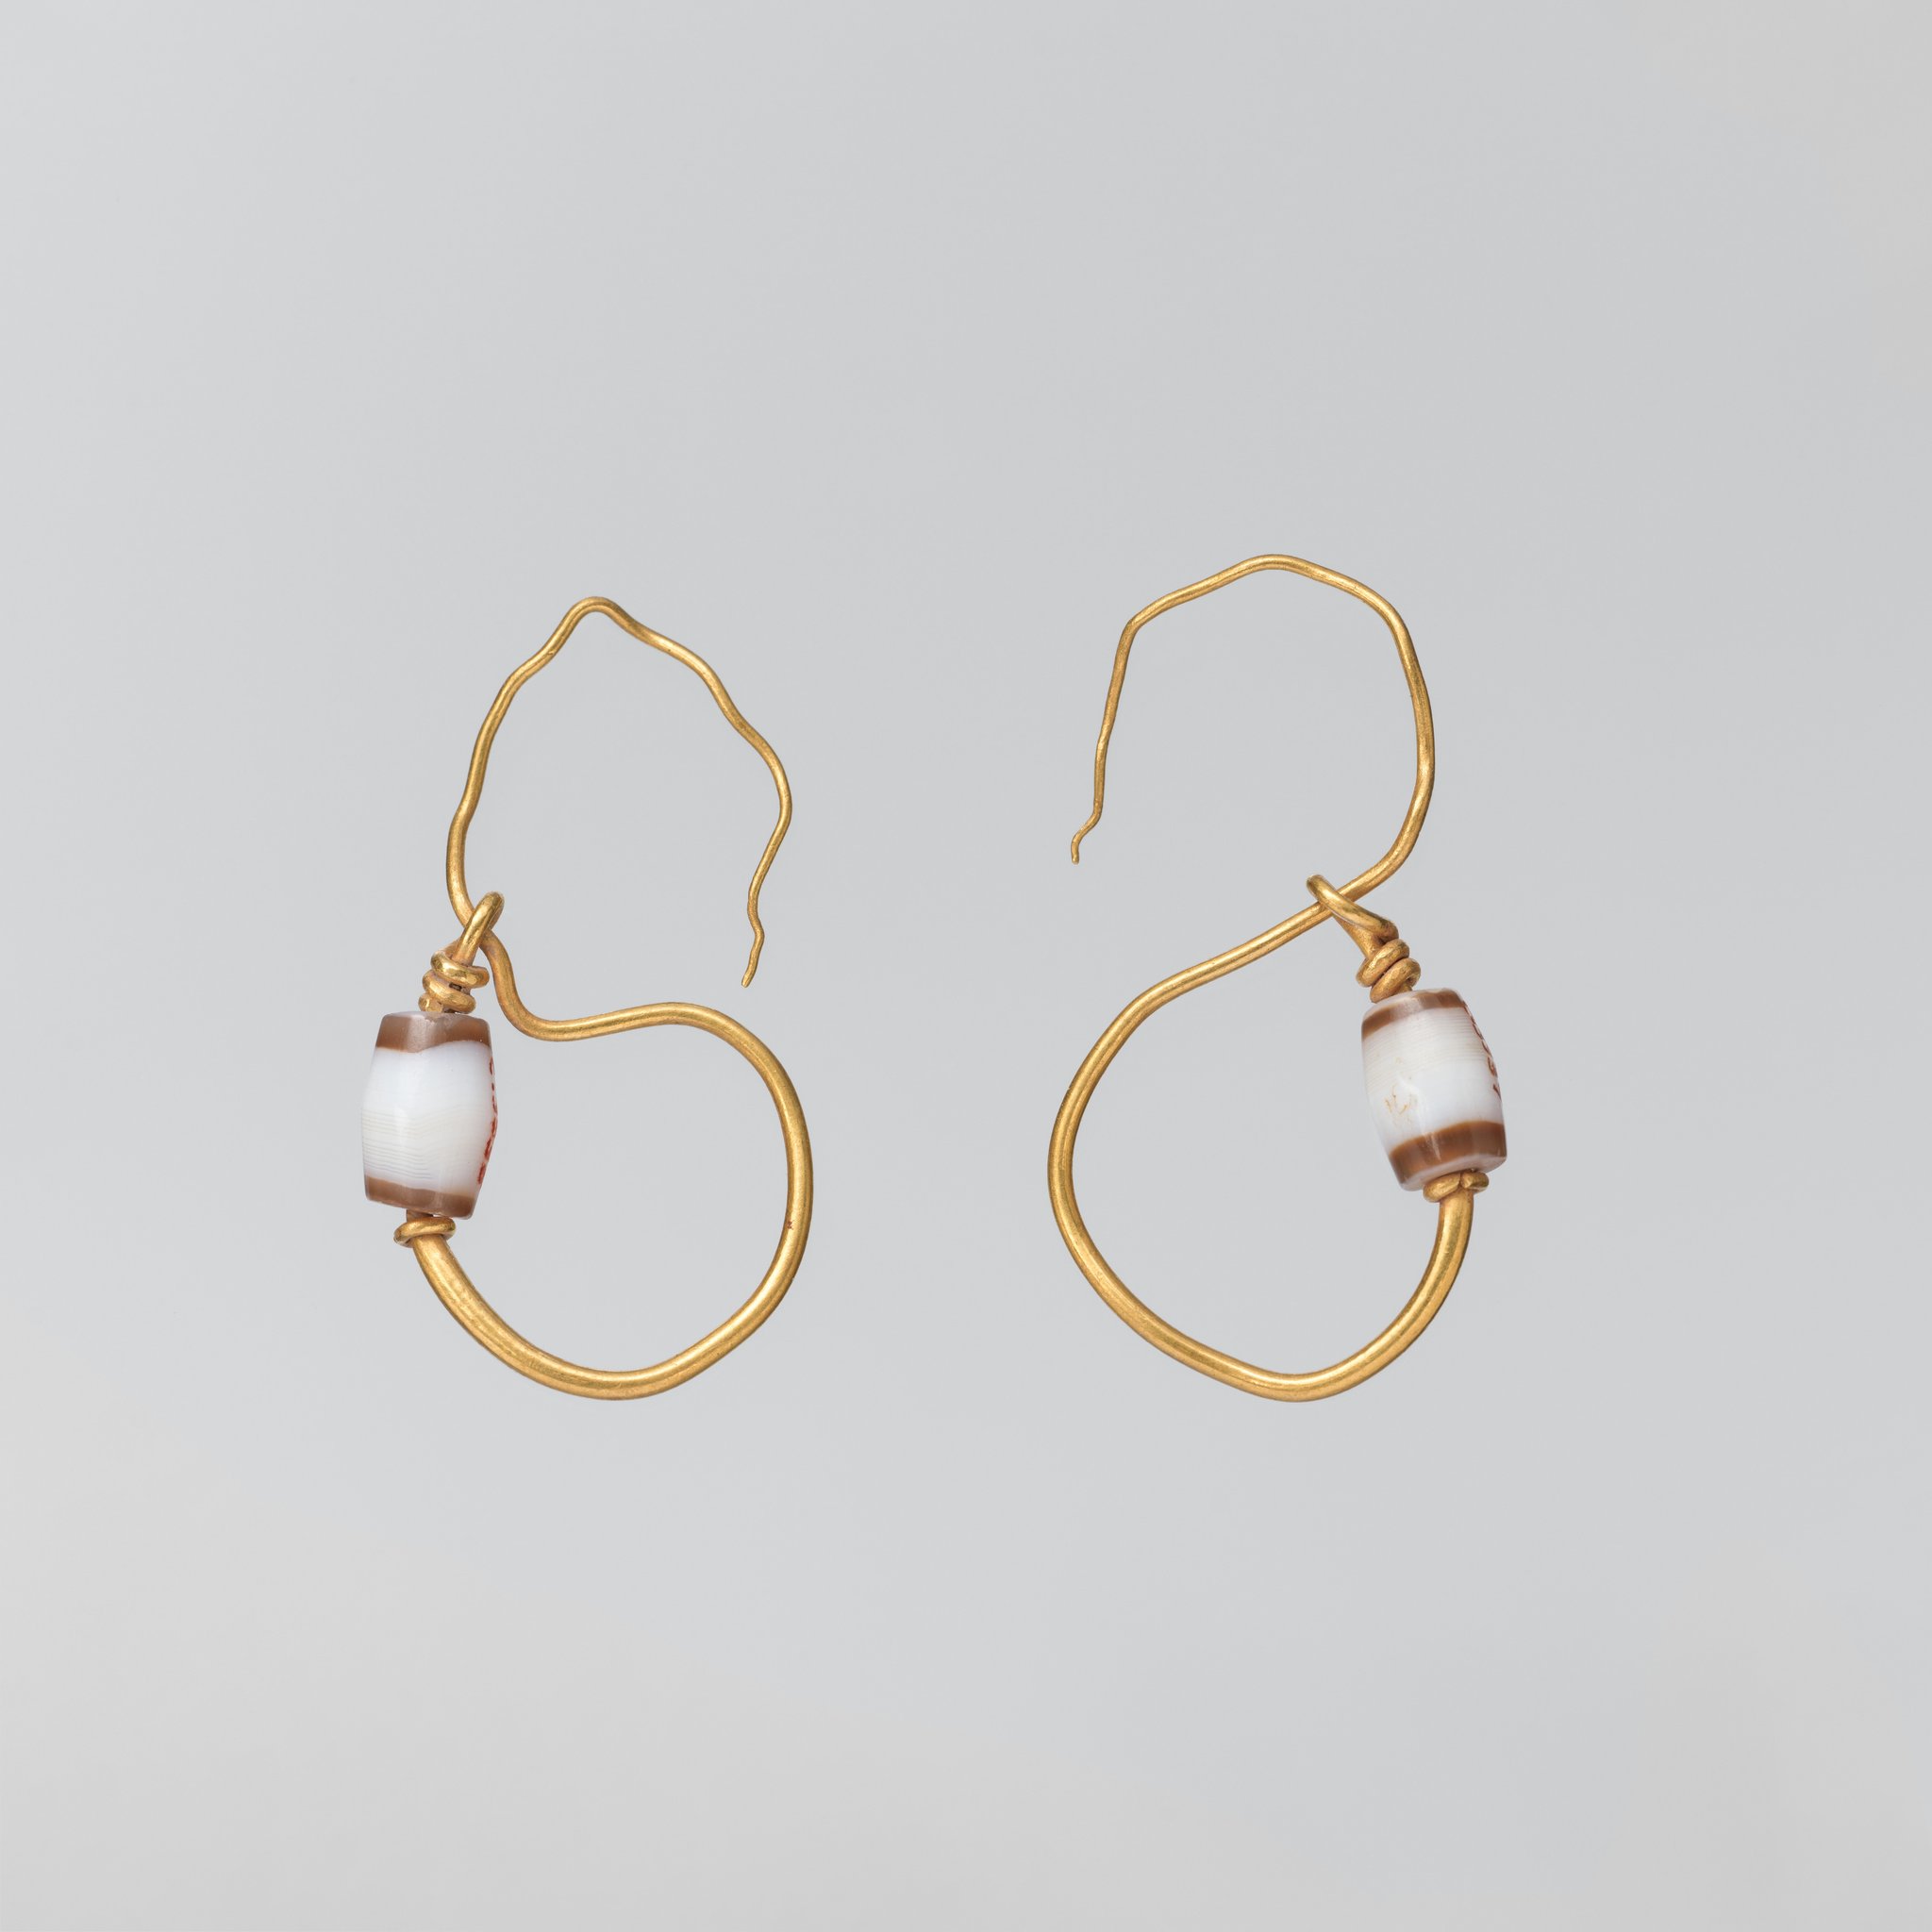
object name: earring, delta shaped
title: Gold and banded agate earring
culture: roman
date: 101-200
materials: stone, gold